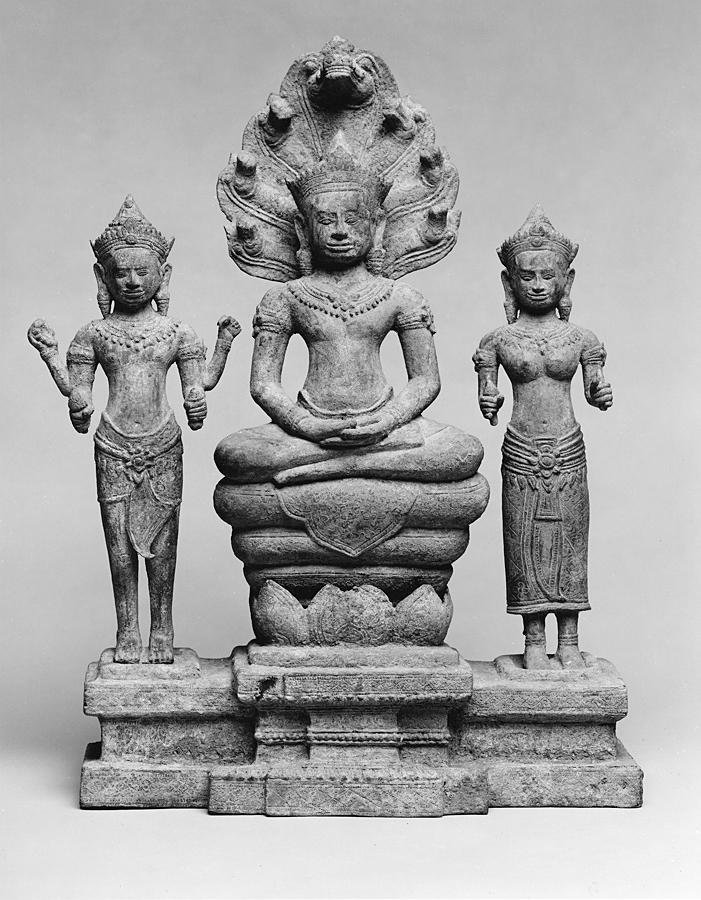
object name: group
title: Naga-Protected Buddha Flanked by Avalokiteshvara and Prajnaparamita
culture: cambodian or thai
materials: bronze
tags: avalokiteshvara,buddha